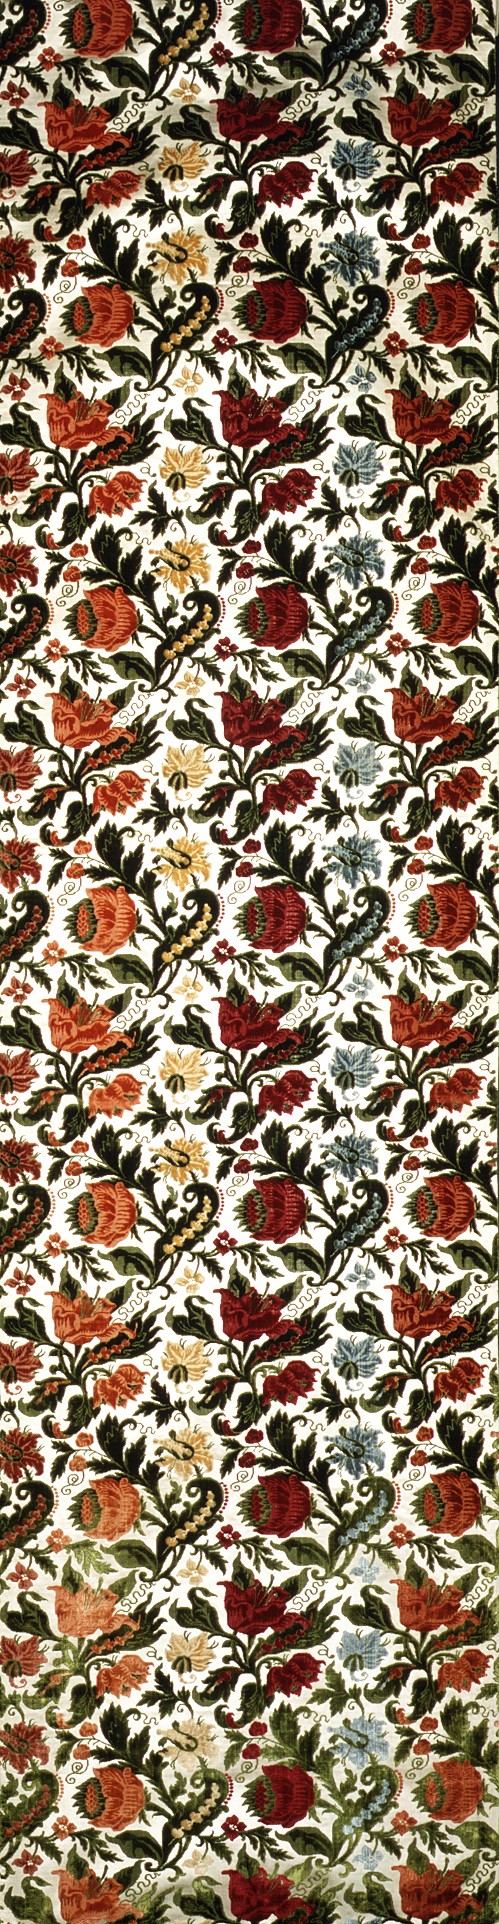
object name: length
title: Length of velvet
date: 1667-1733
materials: silk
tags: flowers